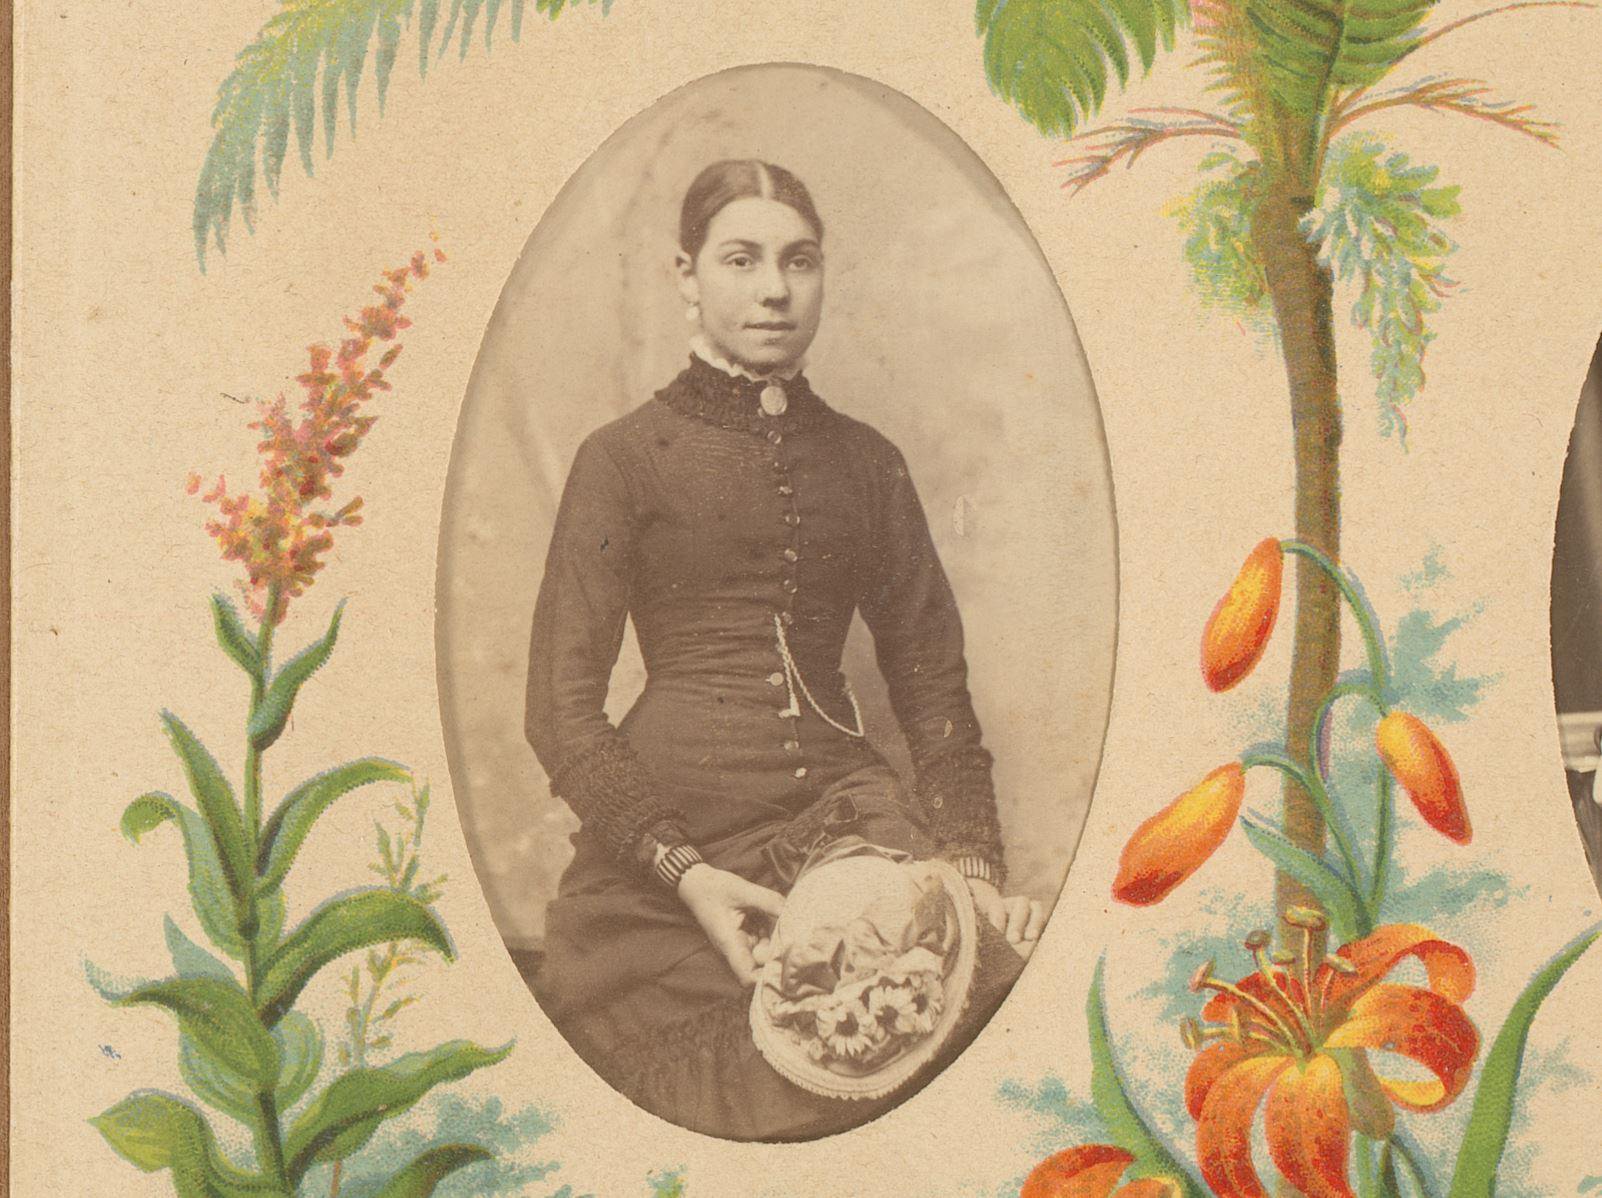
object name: carte de visite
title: Portret van een zittende vrouw met hoed in de hand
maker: robert hider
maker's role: fotograaf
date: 1850-1900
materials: cardboard, photographic support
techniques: albumen print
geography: gravesend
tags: historical persons - bb - woman, head-gear: hat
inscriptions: inscription: ‘Portrait & Landscape/ Photographer,/ Robt Hider/ 183, Parrock Street,/ Gravesend./ Negatives kept,/ Copies may be had at any time./ No.’